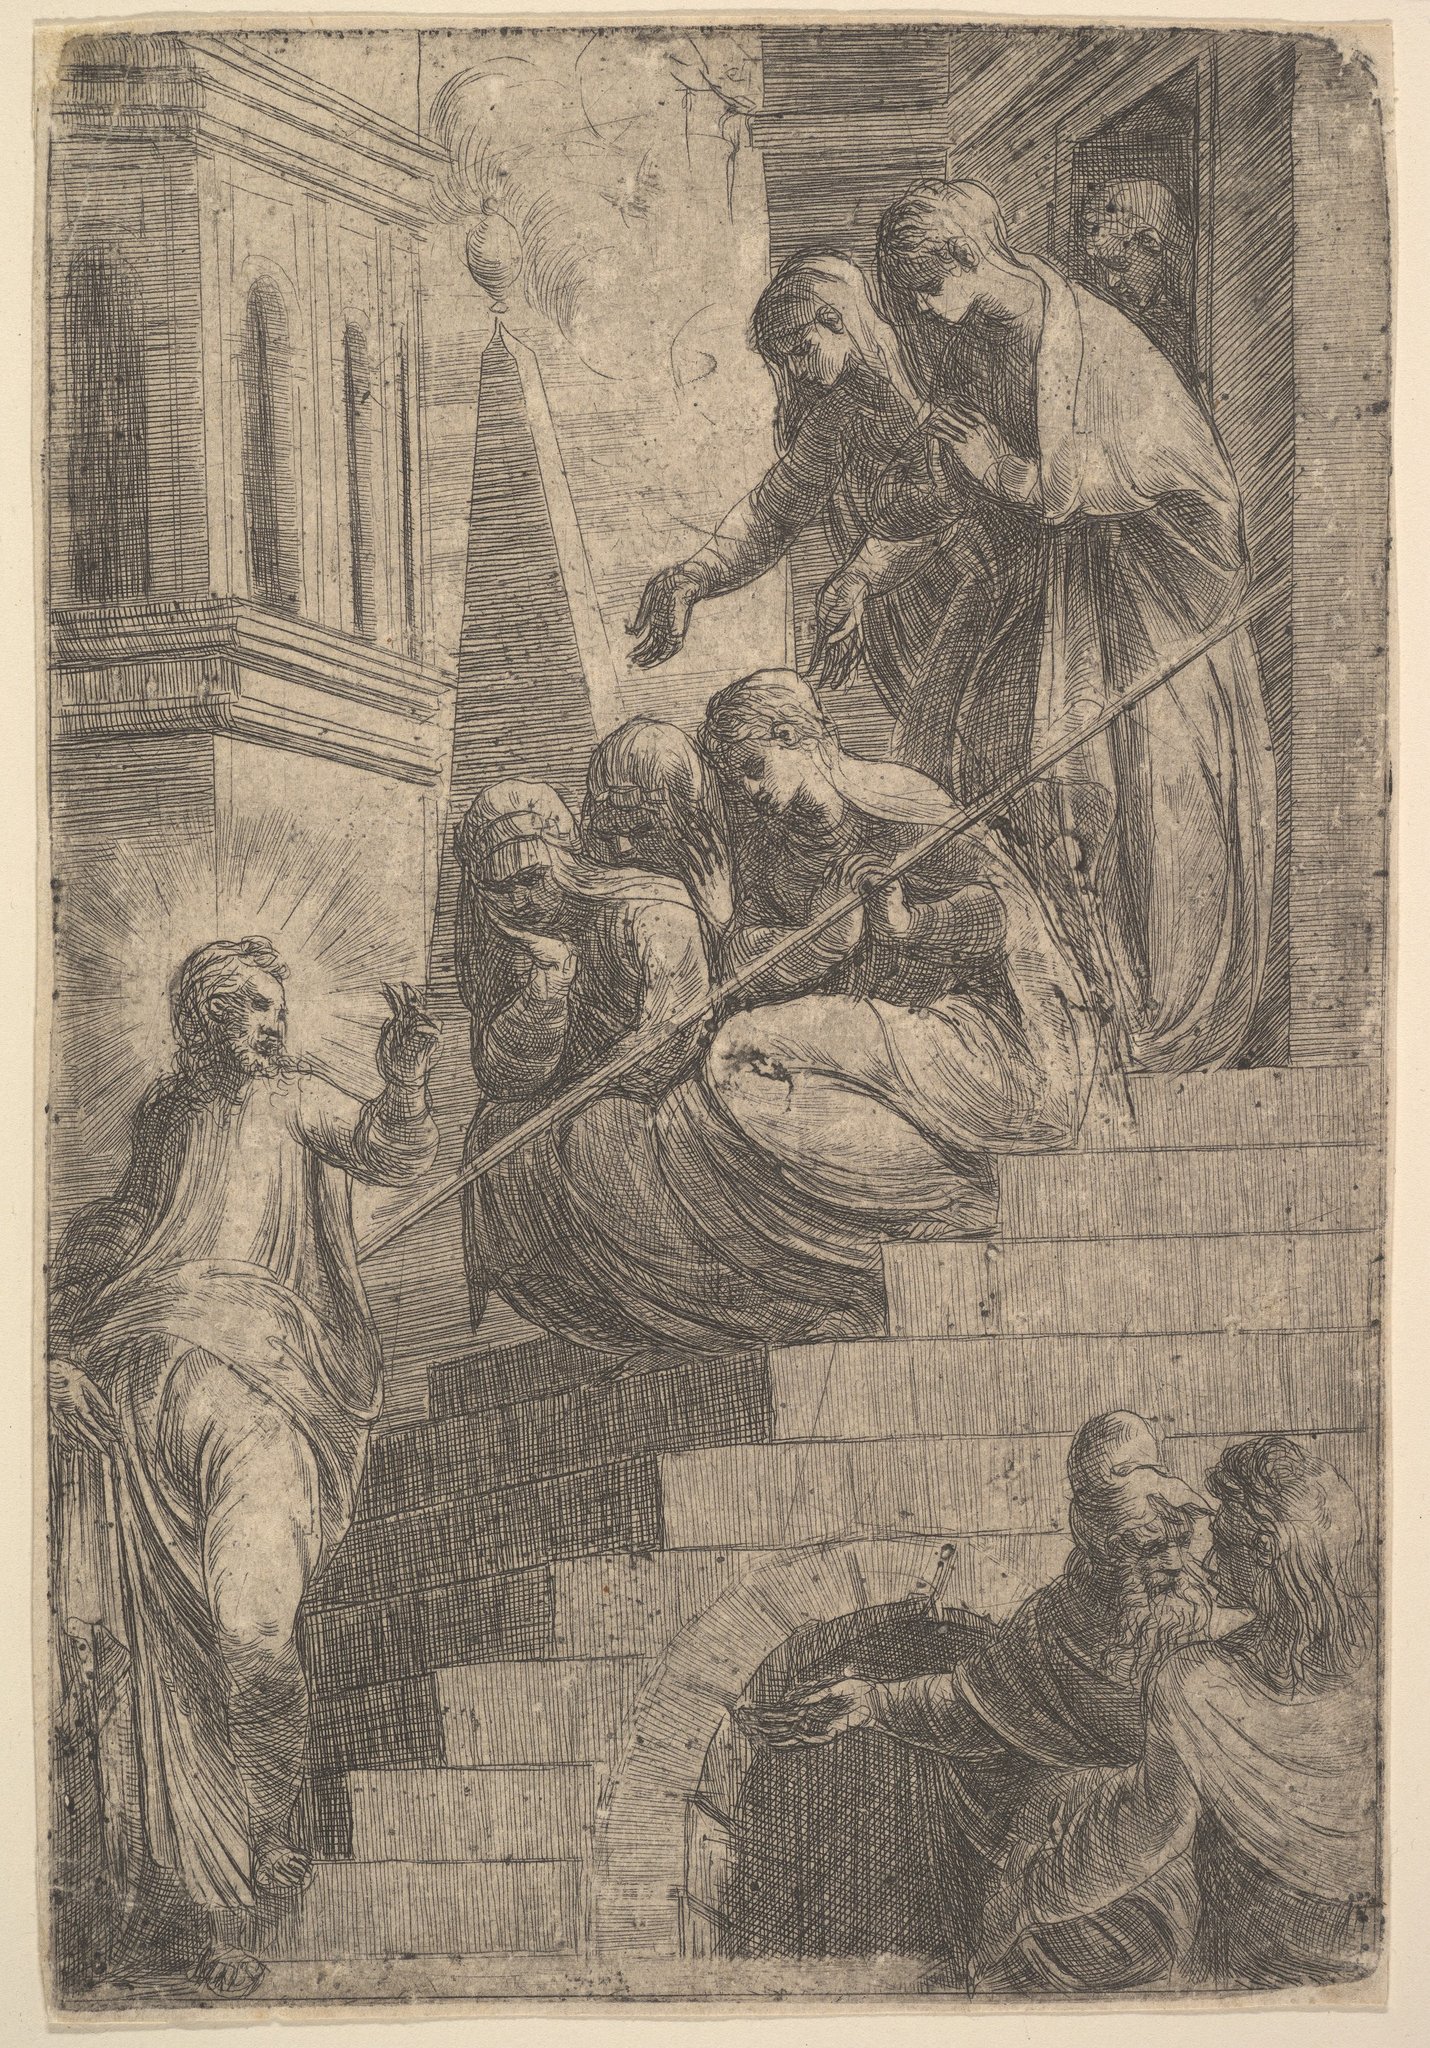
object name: print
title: Christ addressing a group of women seated and standing on steps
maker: andrea schiavone (andrea meldola)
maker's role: artist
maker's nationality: italian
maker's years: 1510-1563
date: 1541-1544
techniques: etching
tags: women,christ